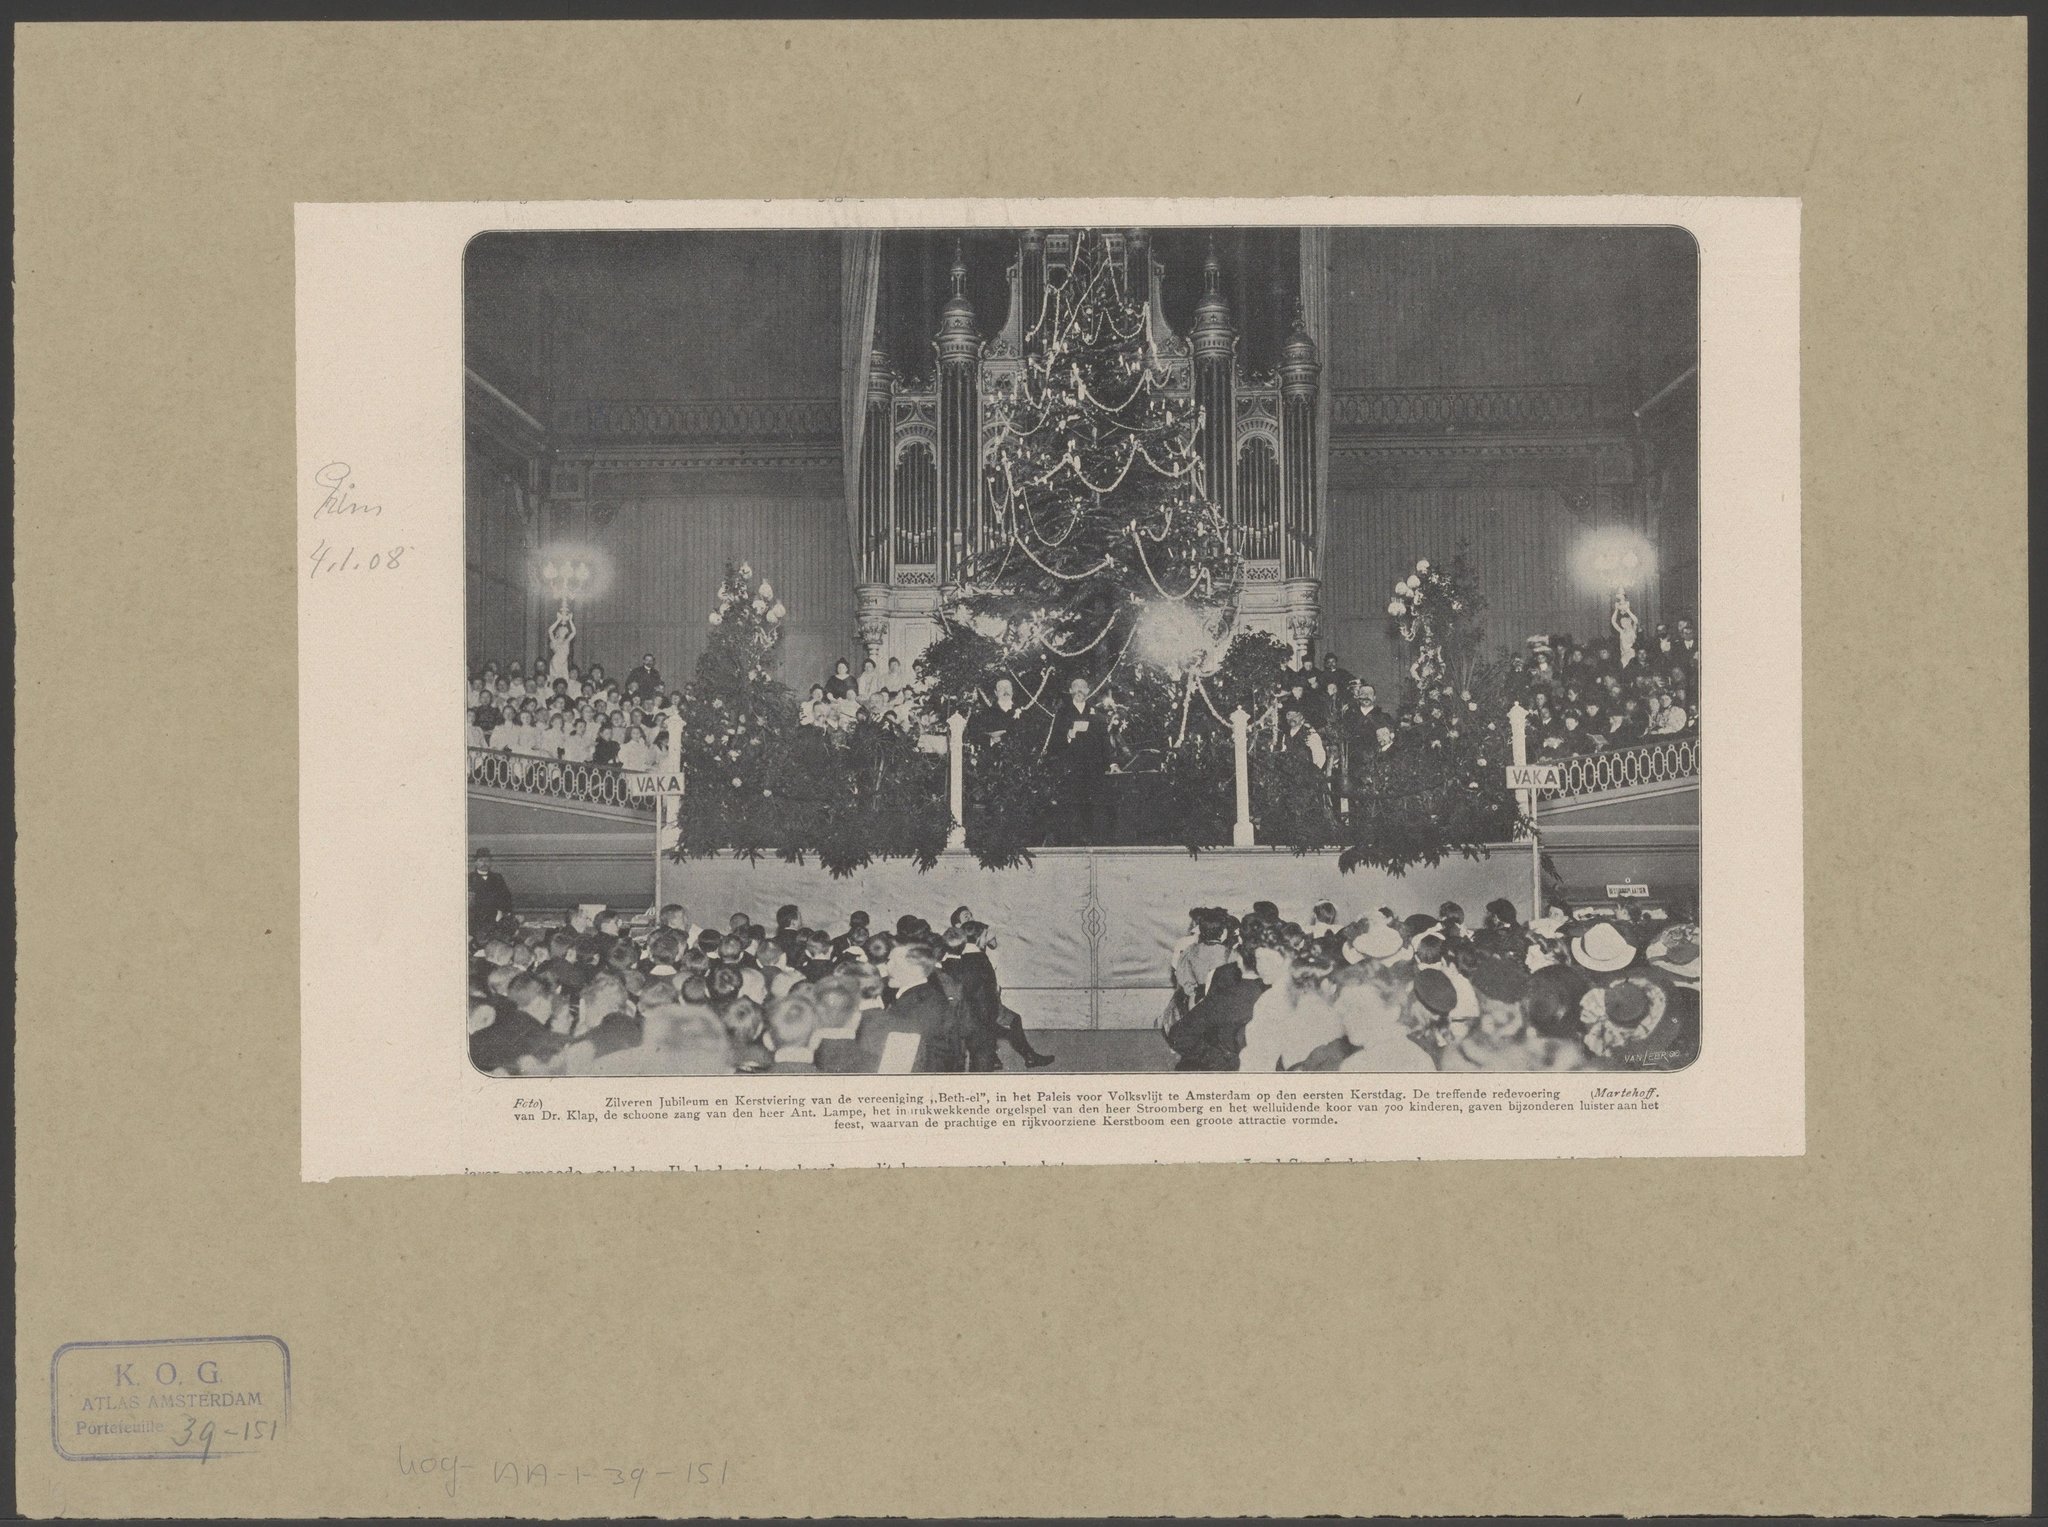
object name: photomechanical print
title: Kerstviering van vereniging Beth-el in het Paleis voor Volksvlijt te Amsterdam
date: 1908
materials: paper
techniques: letterpress printing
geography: amsterdam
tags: christmas (non-liturgical celebration), christmas tree, organ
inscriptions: collector's mark: Lugt 1641b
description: Onderwerpsrubriek binnen de Atlas Amsterdam: Armwezen en liefdadige instellingen: IV. Prenten betrekking hebbende op Philantropie.